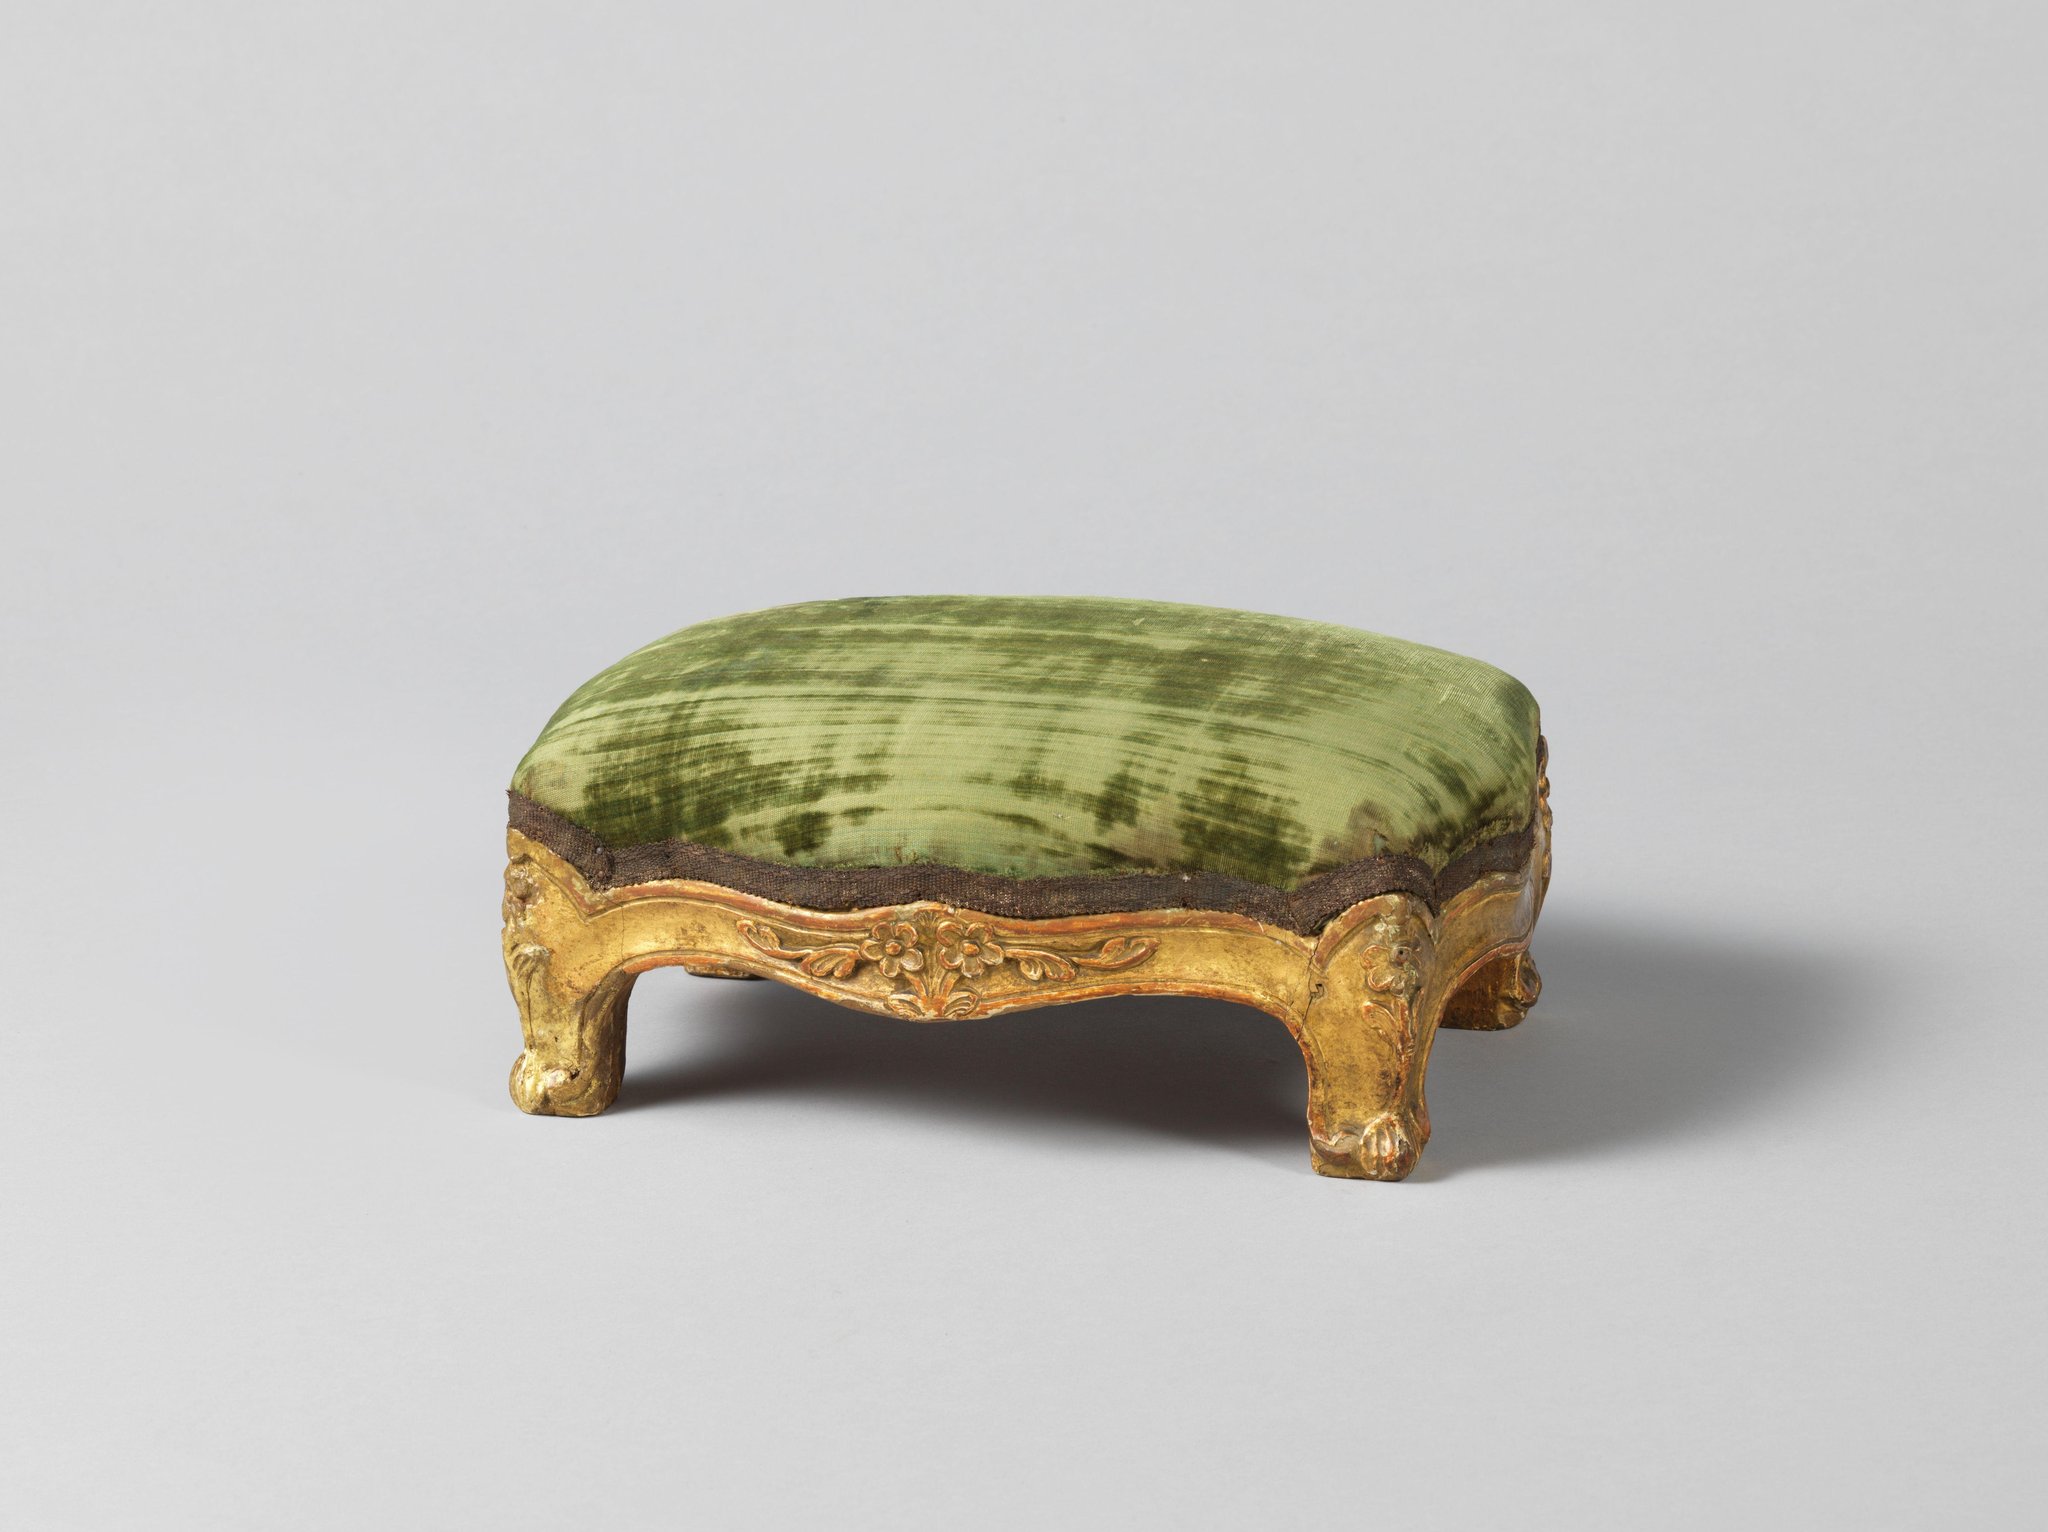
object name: footstool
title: Voetenbank bij Stadhoudersstoel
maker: Anonymous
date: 1768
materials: thread, velvet, wood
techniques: gilding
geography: the hague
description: Stadholder's chair with footstool. Walnut, gilded, upholstered with velvet trimmed with silver and gold braid. Probably The Hague, 1768 (?). The chair, one of a pair, was probably used during the visit of Stadholder Prince William V and his consort, Princess Wilhelmina, to Amsterdam in 1768. On loan from the City of Amsterdam.